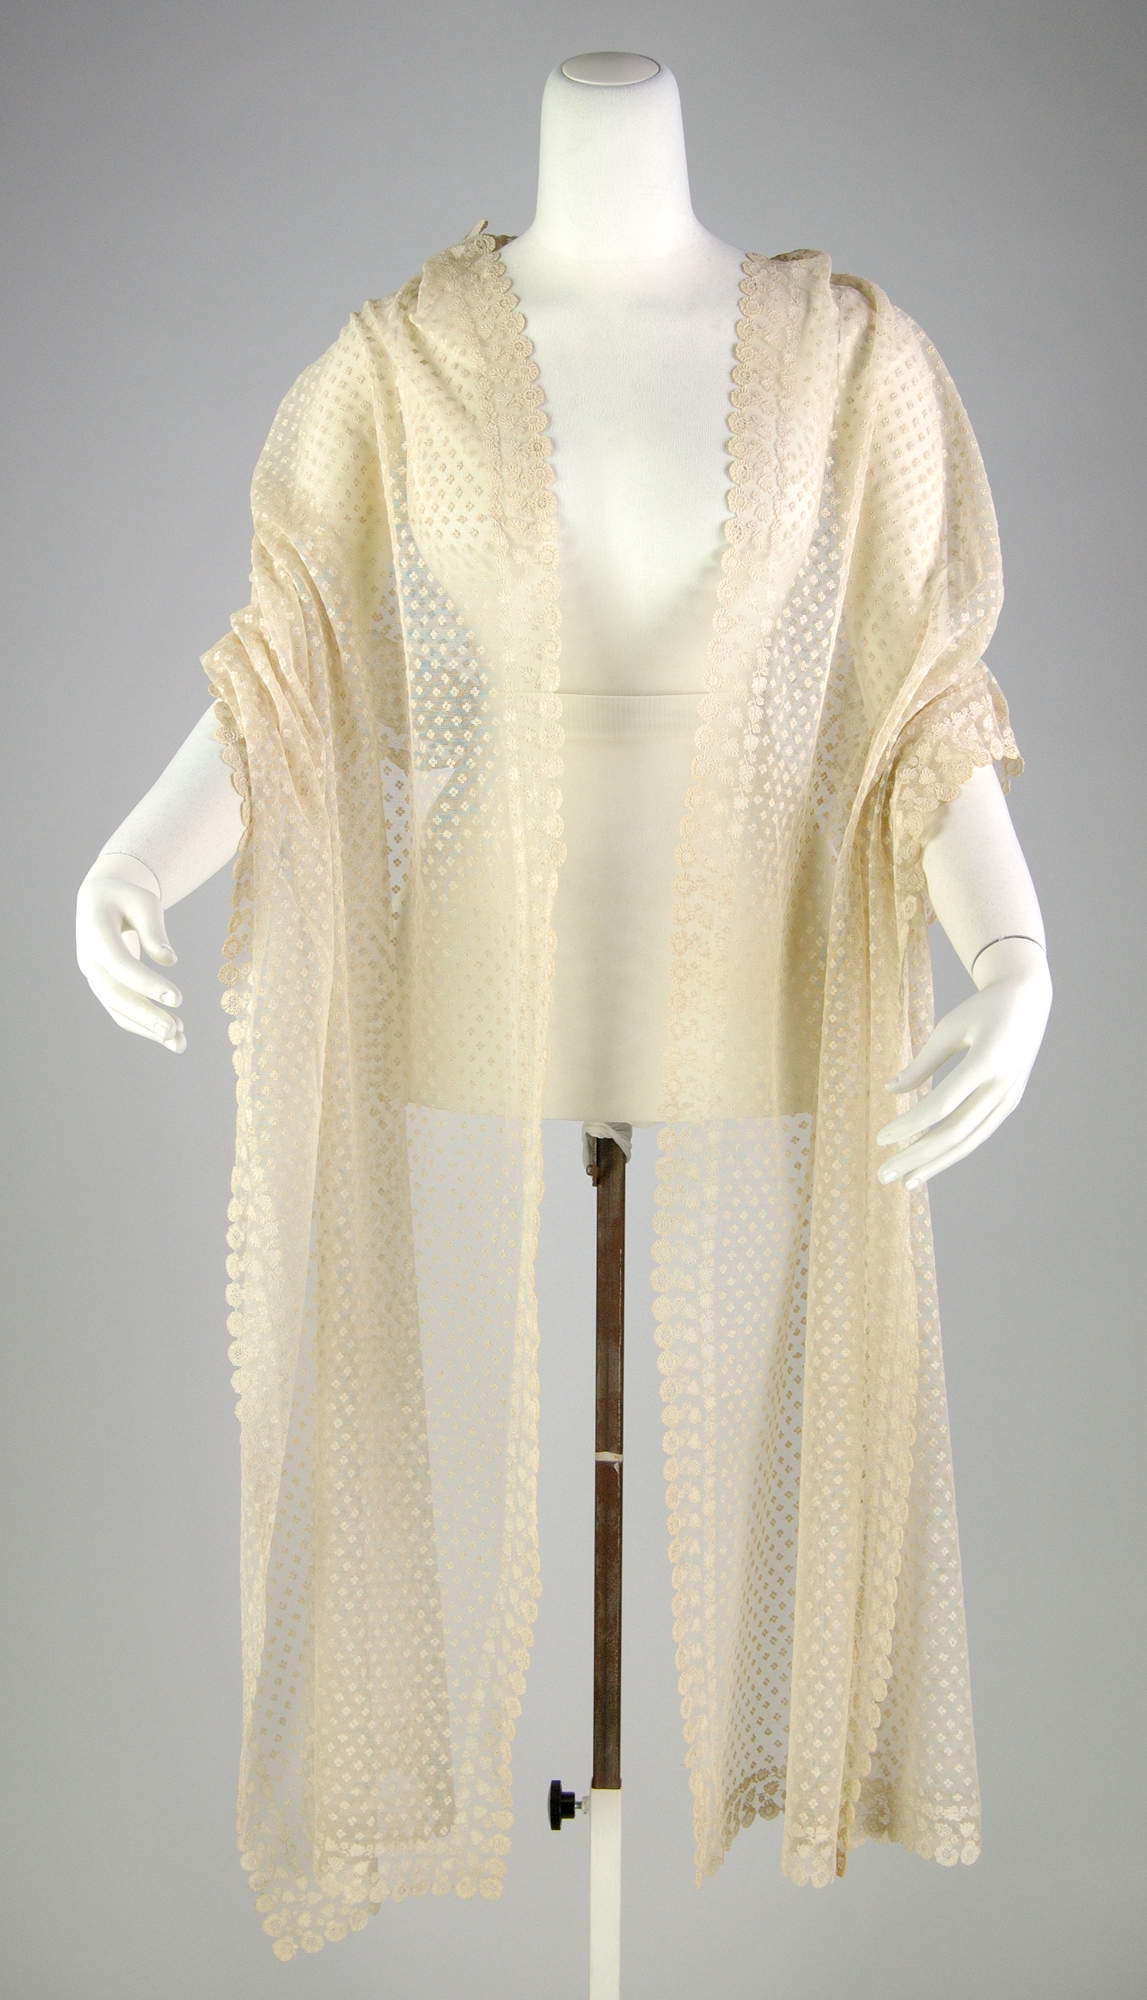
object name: stole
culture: belgian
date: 1830-1850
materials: linen, silk